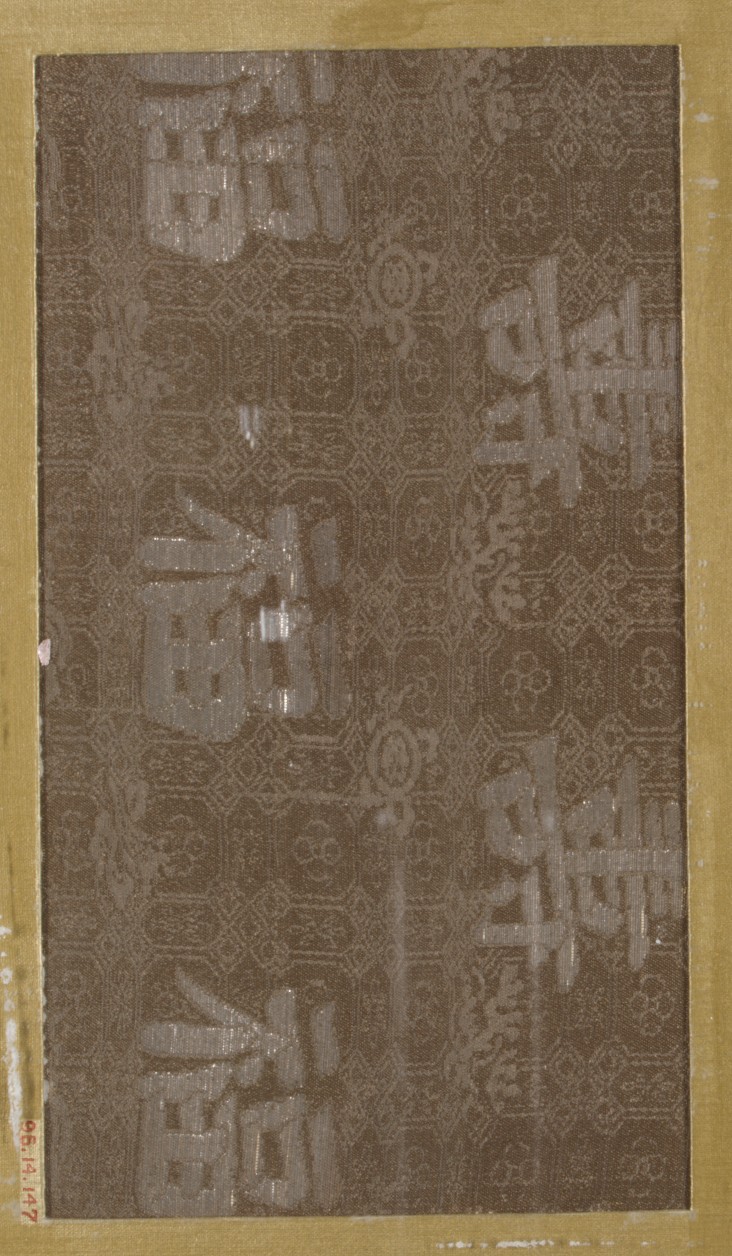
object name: piece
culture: japanese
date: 1801-1900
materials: silk